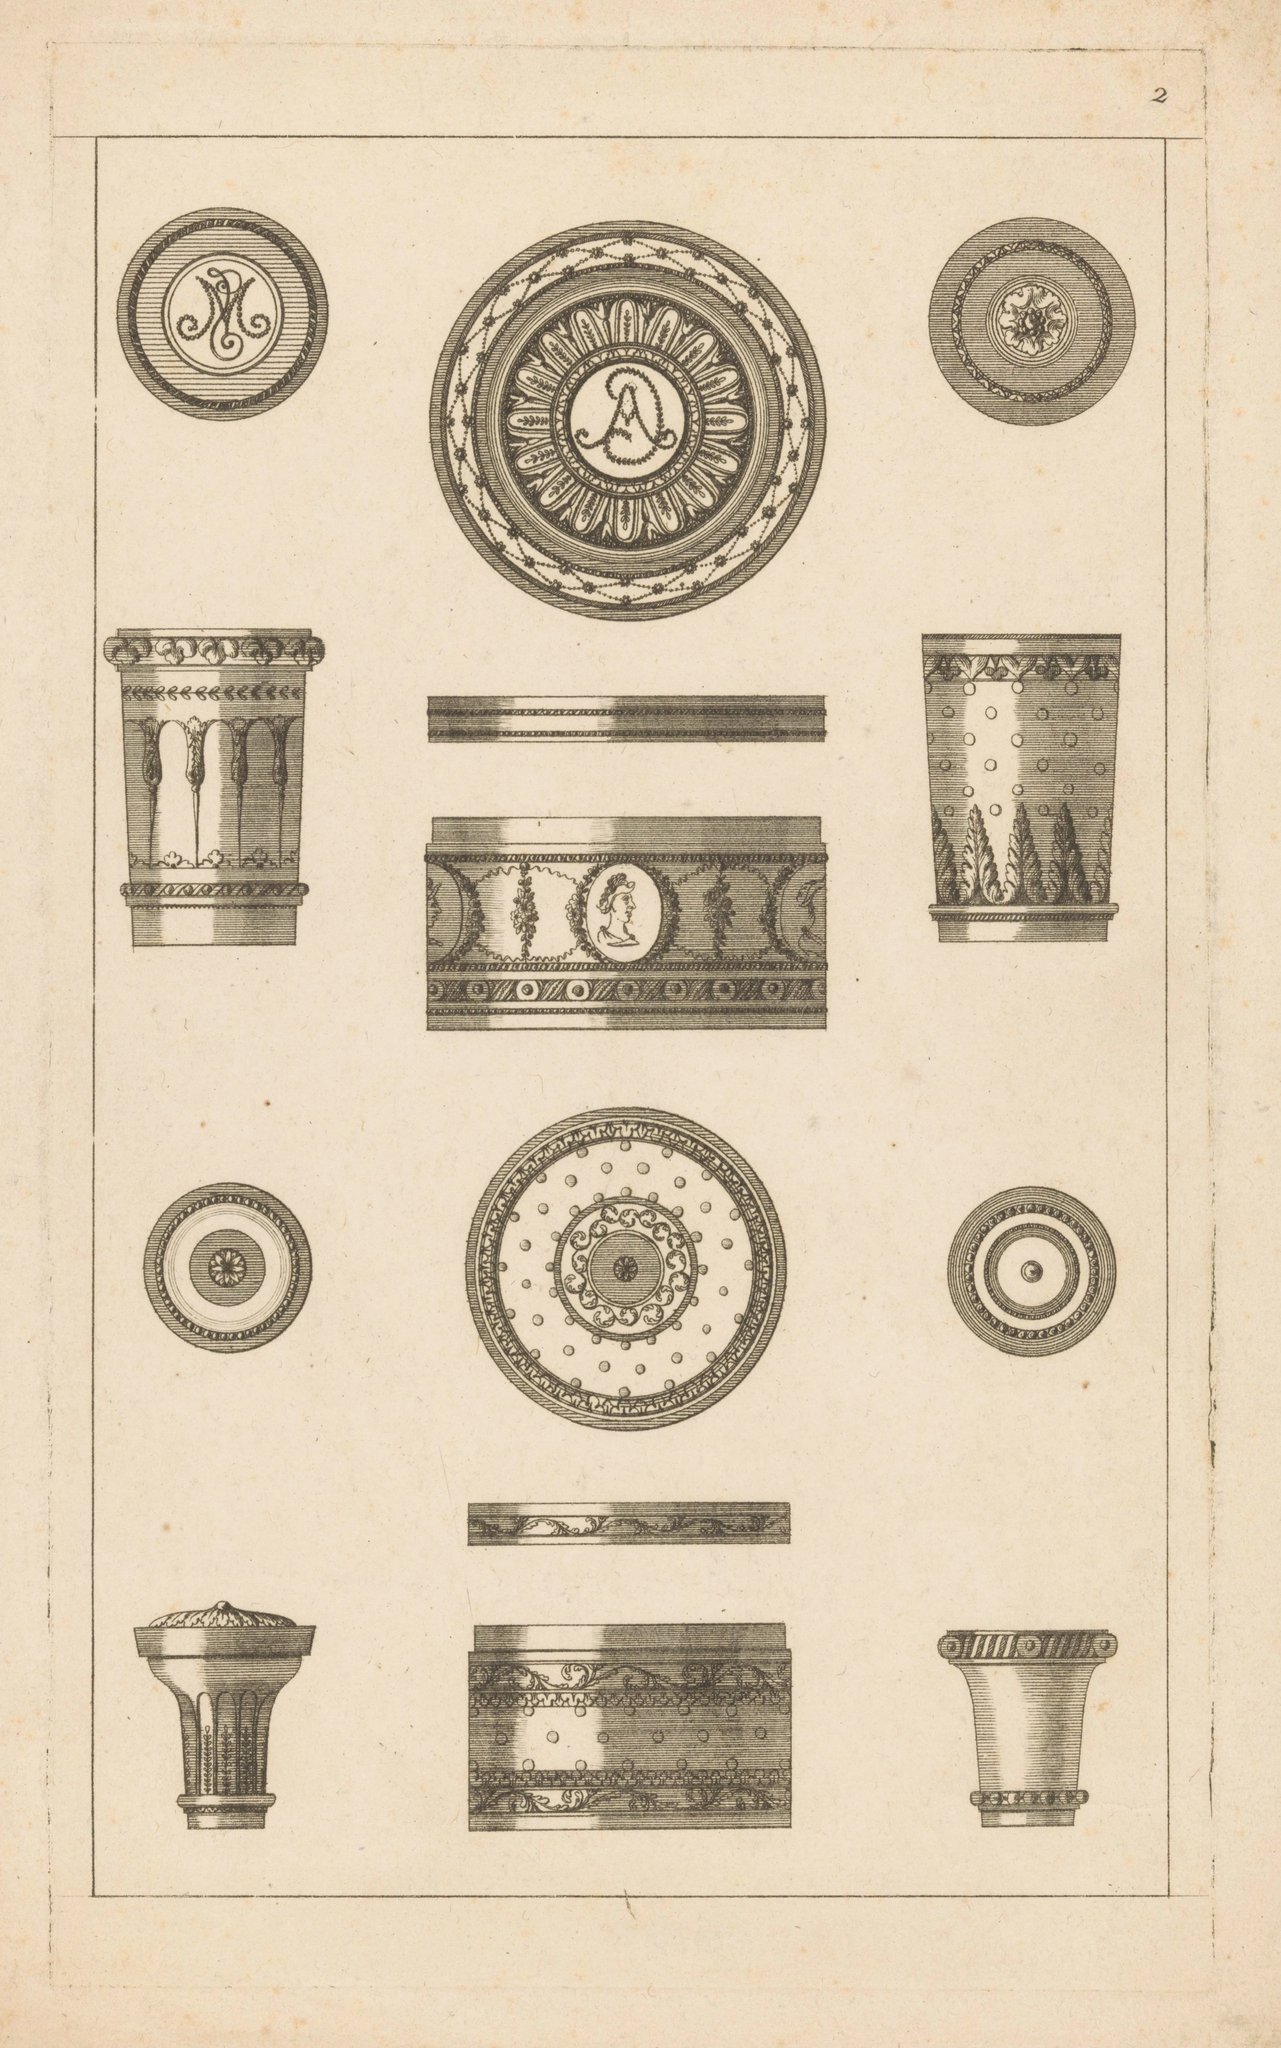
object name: print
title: Juwelendozen, knoppen en zegels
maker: jean baptiste fay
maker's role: print maker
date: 1784-1796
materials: paper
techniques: engraving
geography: paris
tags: walking-stick, staff, seal, stamp, jewel-box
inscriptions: collector's mark: Lugt 2760, collector's mark: Lugt 2228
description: Ontwerpen voor vier geornamenteerde knoppen voor wandelstokken (links en rechts), vier zegels (links en rechts) en twee deksels en kleine opbergdozen (in het midden).